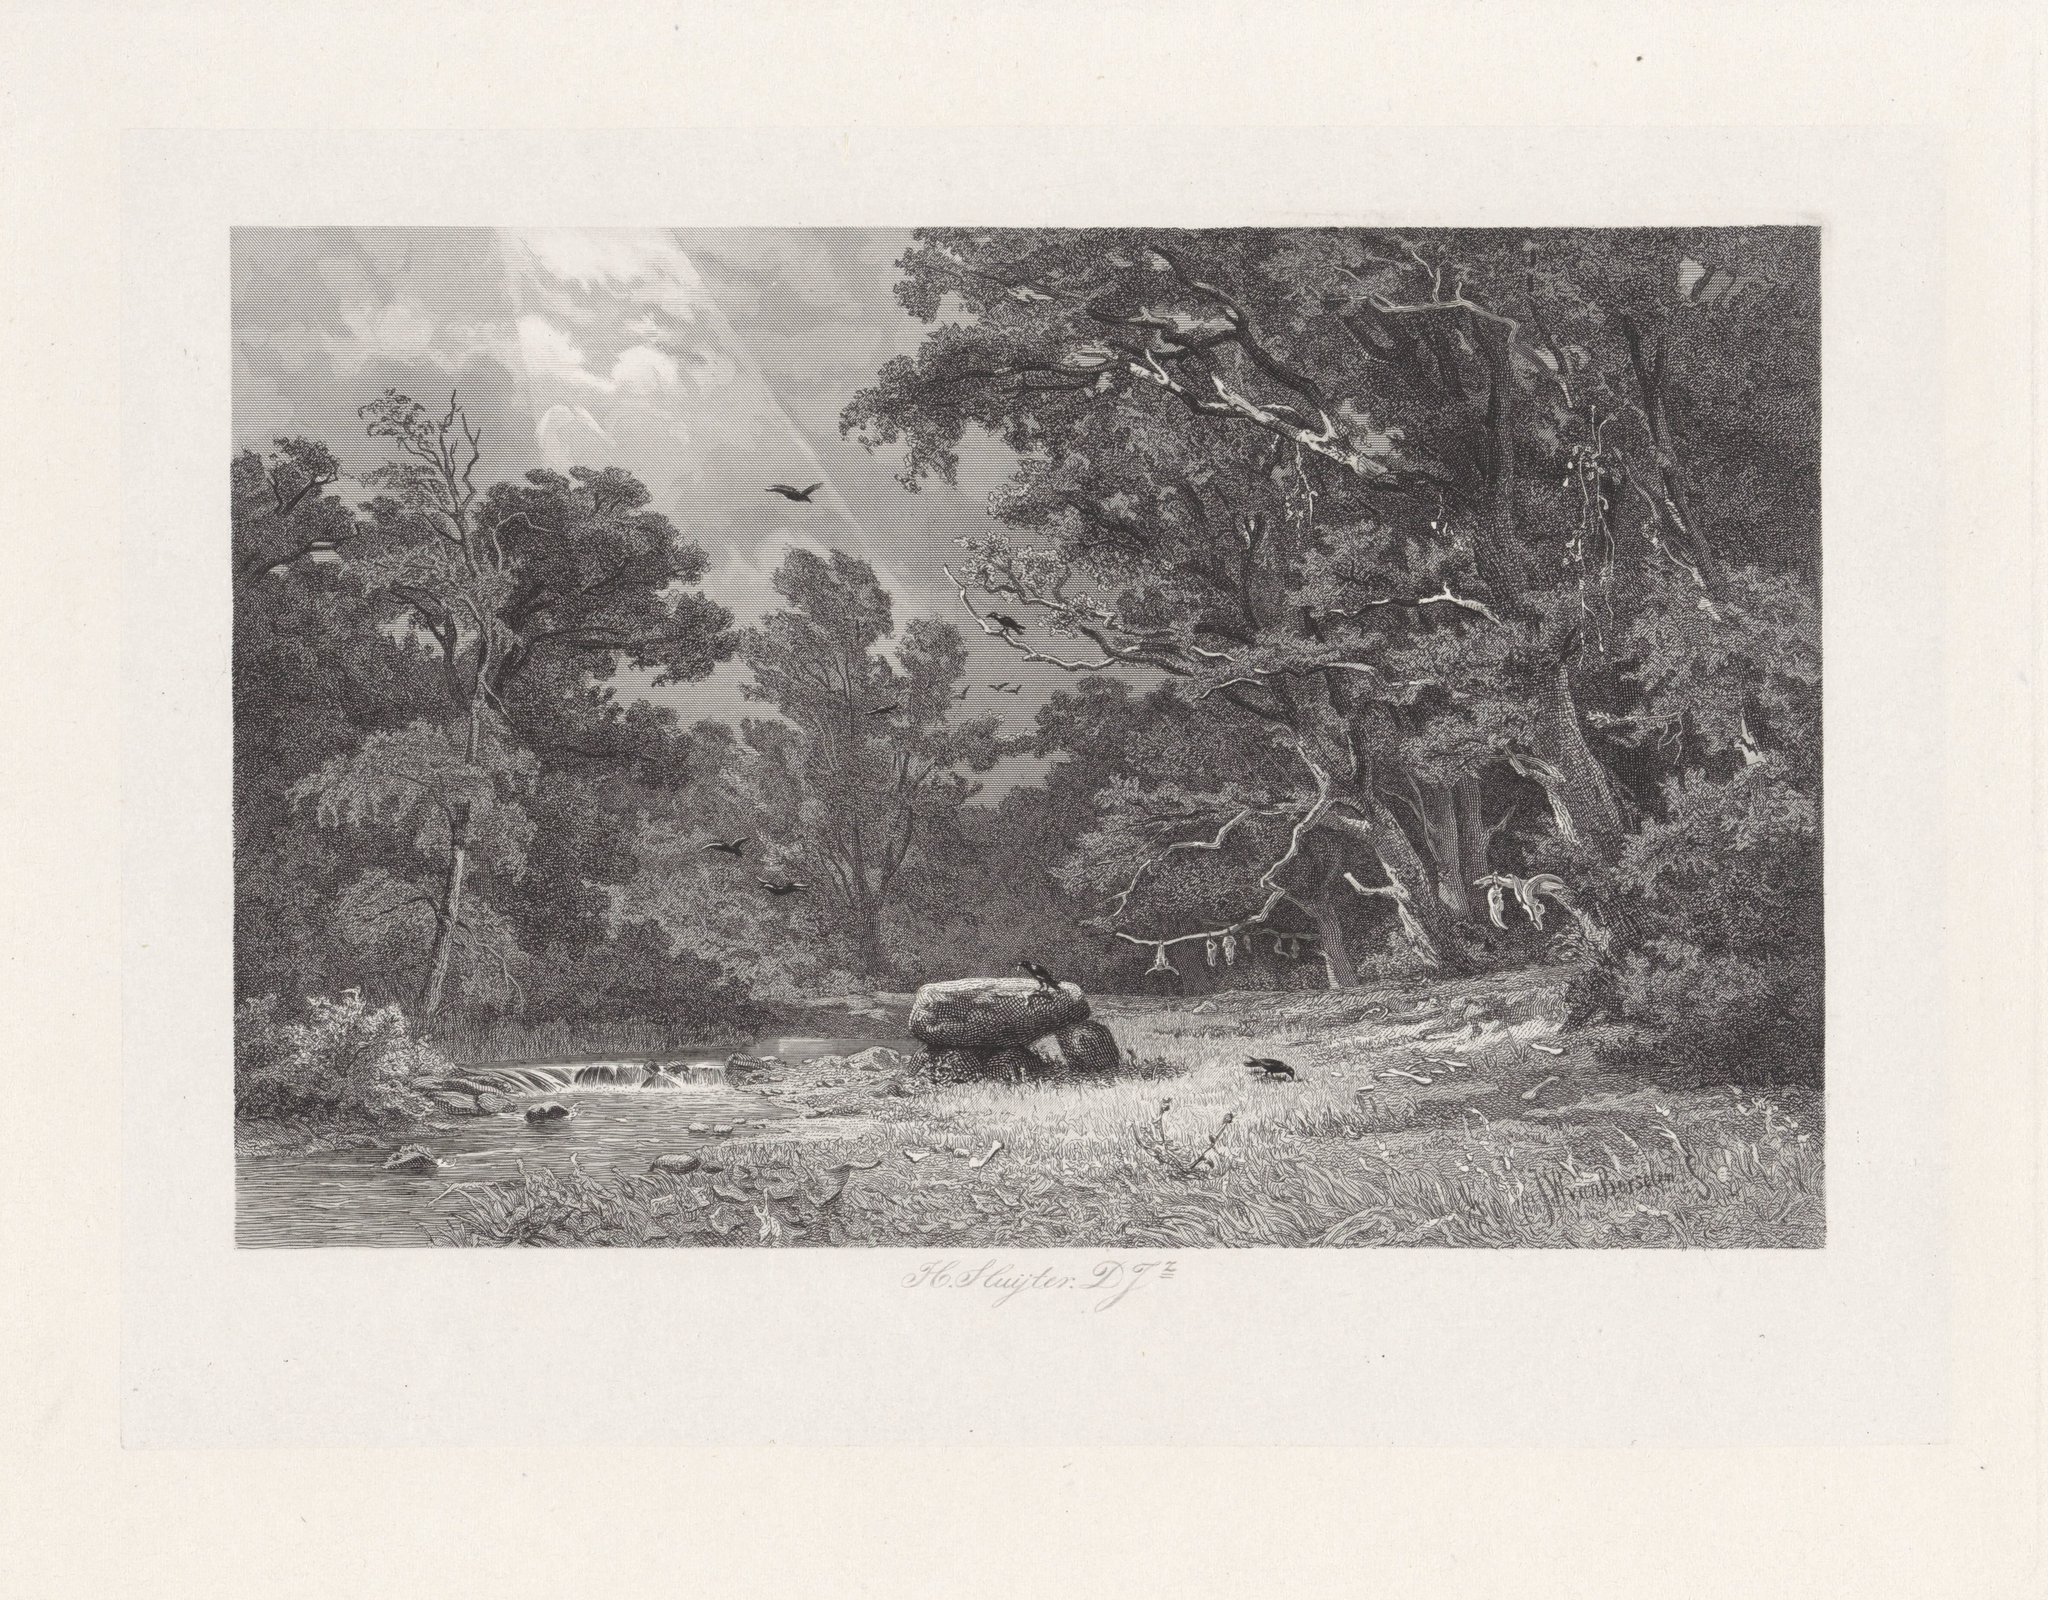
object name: print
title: Germaanse offerplaats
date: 1865-1870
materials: paper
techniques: engraving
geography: netherlands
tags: sacrifice ~ germanic and scandinavian religions, netherlands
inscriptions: collector's mark: Lugt 2228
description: Illustratie voor: J. van Lennep en W. Moll en J. ter Gouw. Nederlands geschiedenis en volksleven in schetsen. Leiden: A.W. Sijthoff, [ca. 1870]. Staalgravures naar de schilderijen van de Historische Galerij der Maatschappij Arti en Amicitiae.